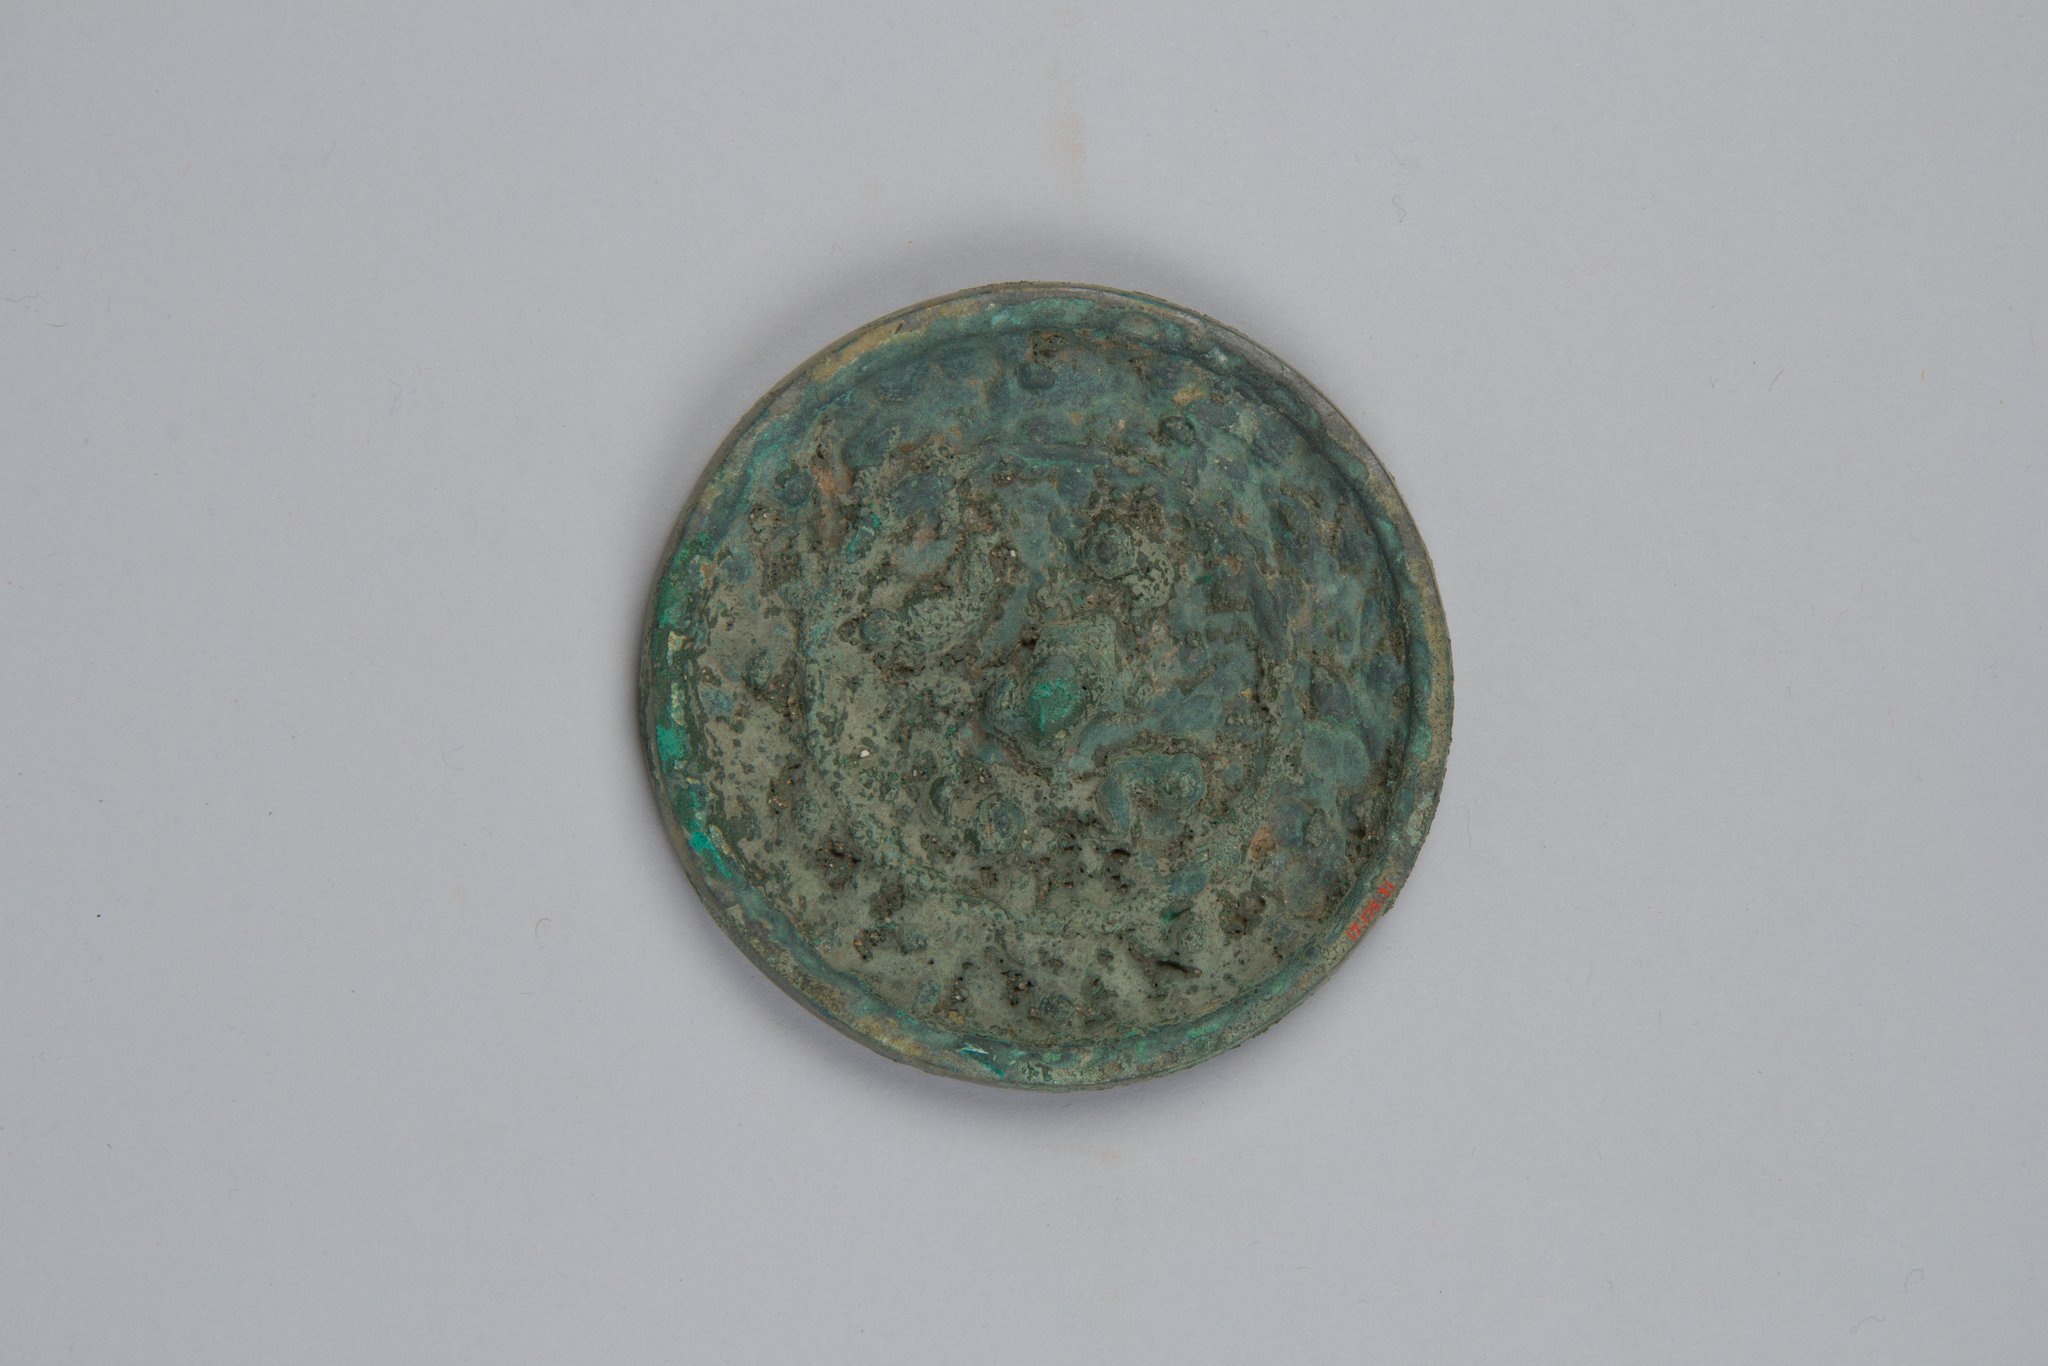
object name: mirror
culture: chinese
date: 618-907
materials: bronze